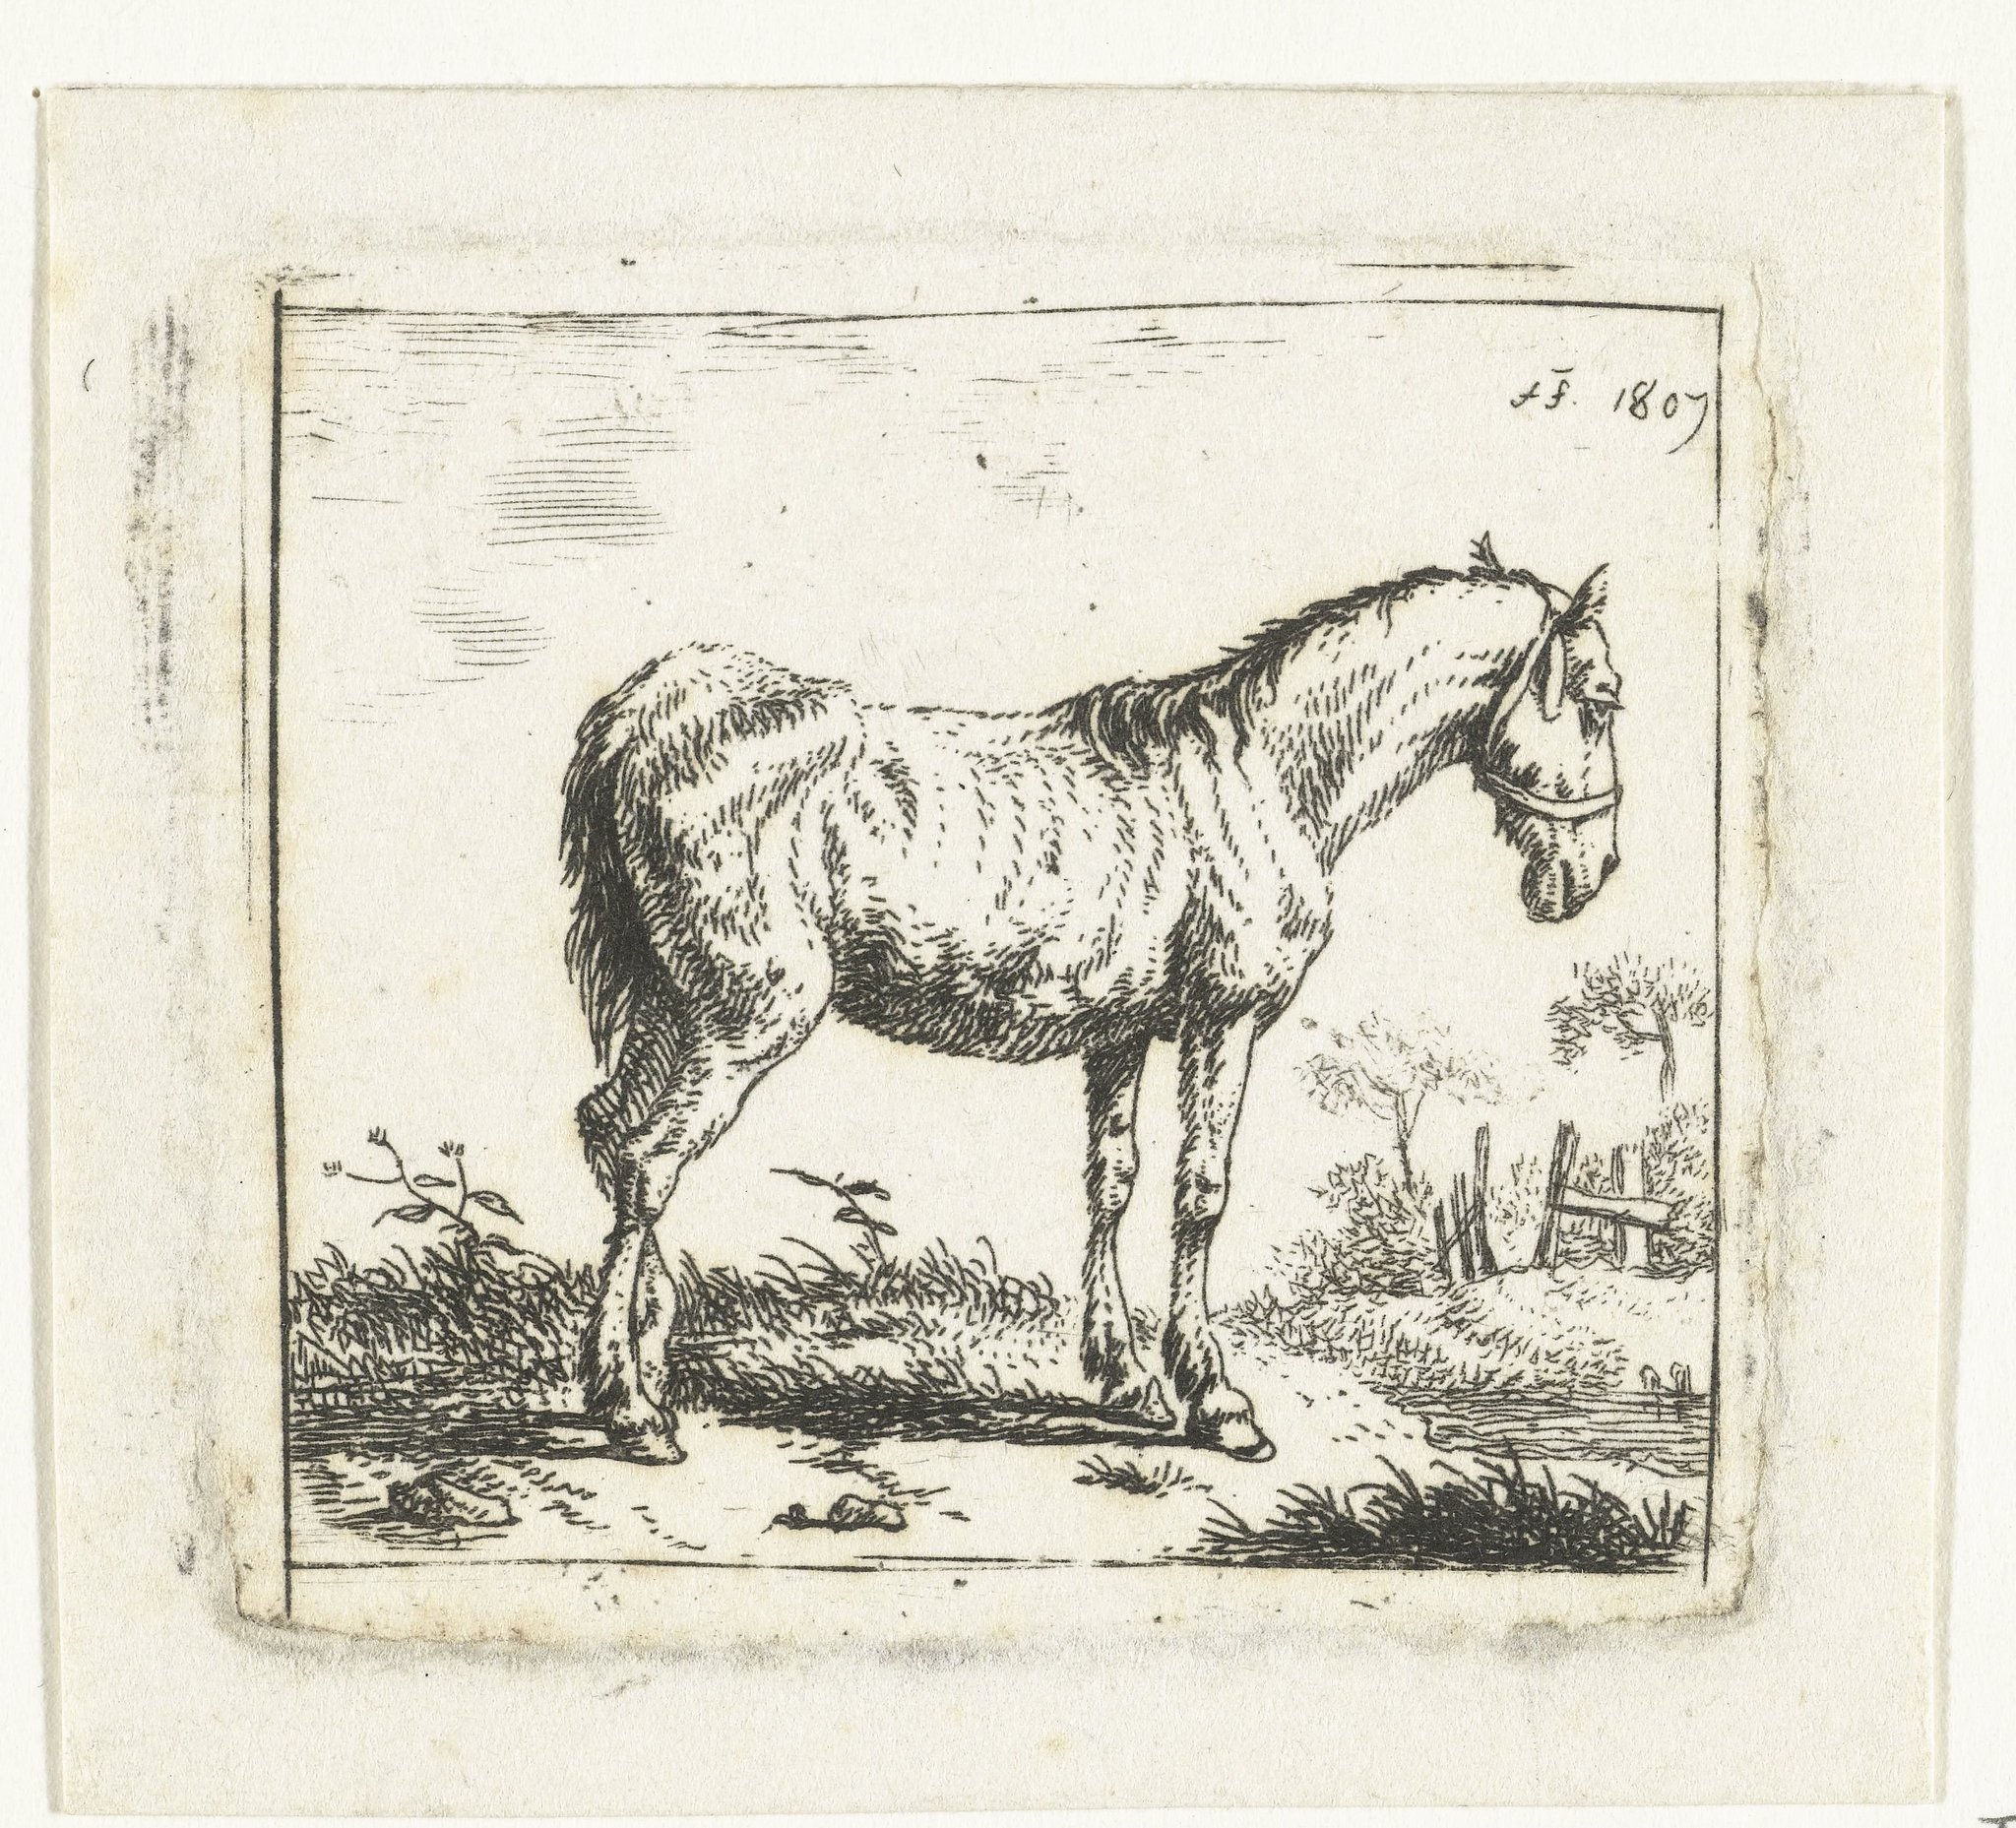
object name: print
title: Mager paard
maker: frédéric théodore faber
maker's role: print maker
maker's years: 1782-1844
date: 1807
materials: paper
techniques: etching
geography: brussels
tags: horse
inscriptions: date